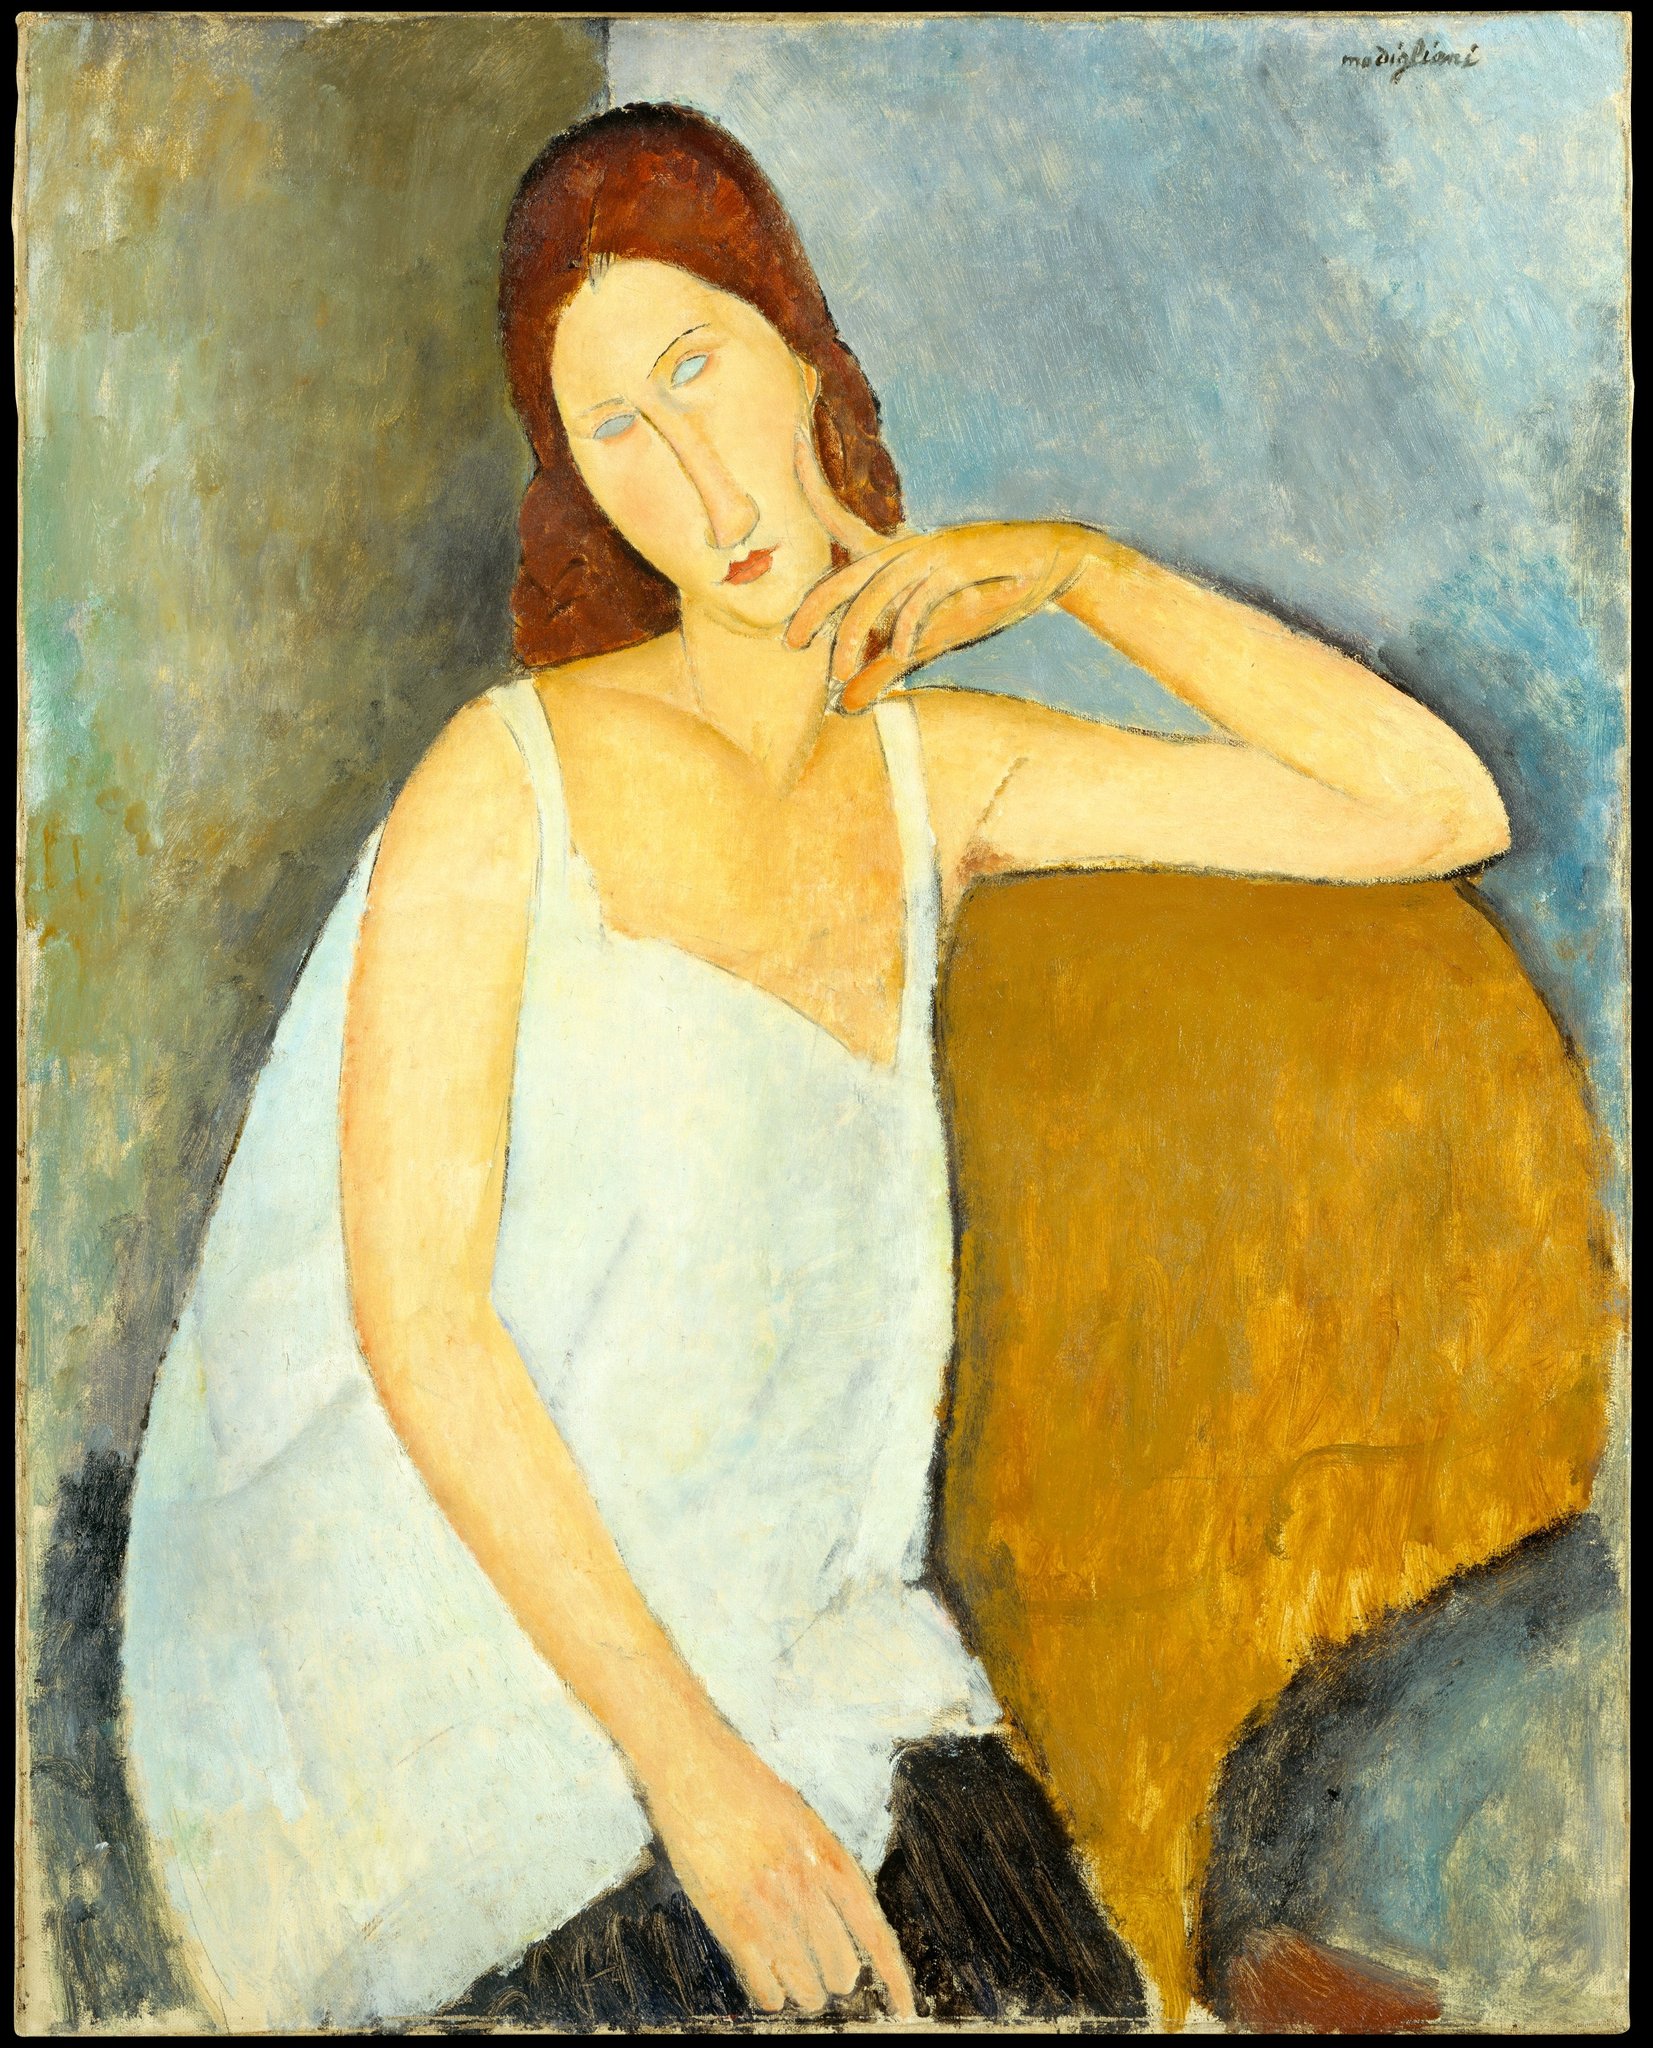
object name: painting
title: Jeanne Hébuterne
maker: amedeo modigliani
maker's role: artist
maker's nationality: italian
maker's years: 1884-1920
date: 1919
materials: canvas, oil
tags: portraits,women